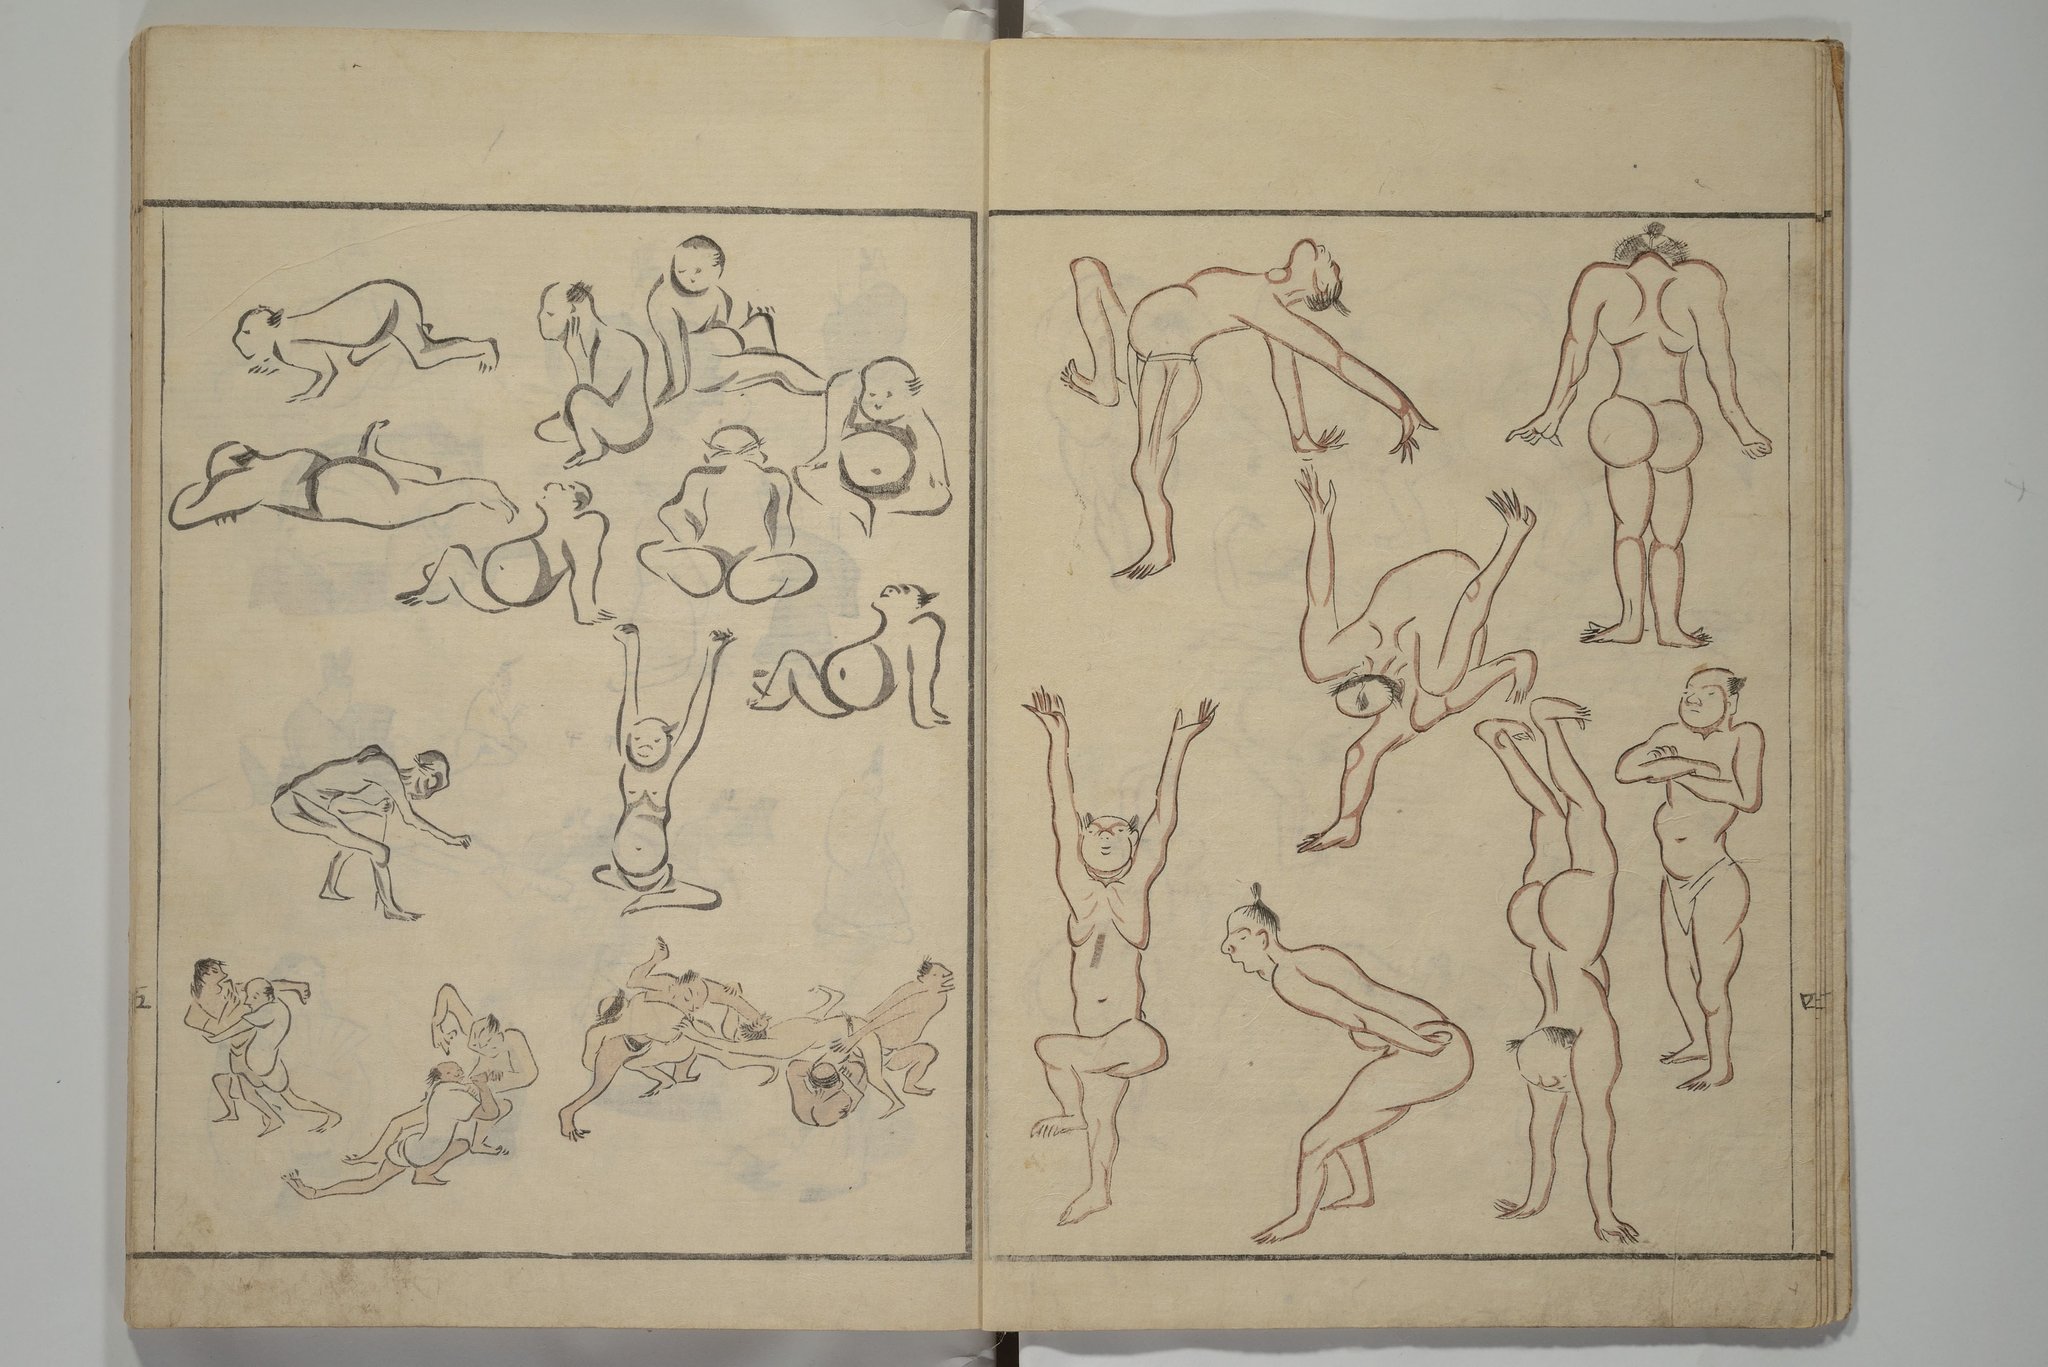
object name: illustrated book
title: How to Draw Figures Simply (Jinbutsu ryakugashiki) 人物略画式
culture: japanese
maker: kuwagata keisai 鍬形蕙斎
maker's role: artist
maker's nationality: japanese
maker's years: 1764-1824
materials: ink, paper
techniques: woodblock print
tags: men,women,horses,wrestling